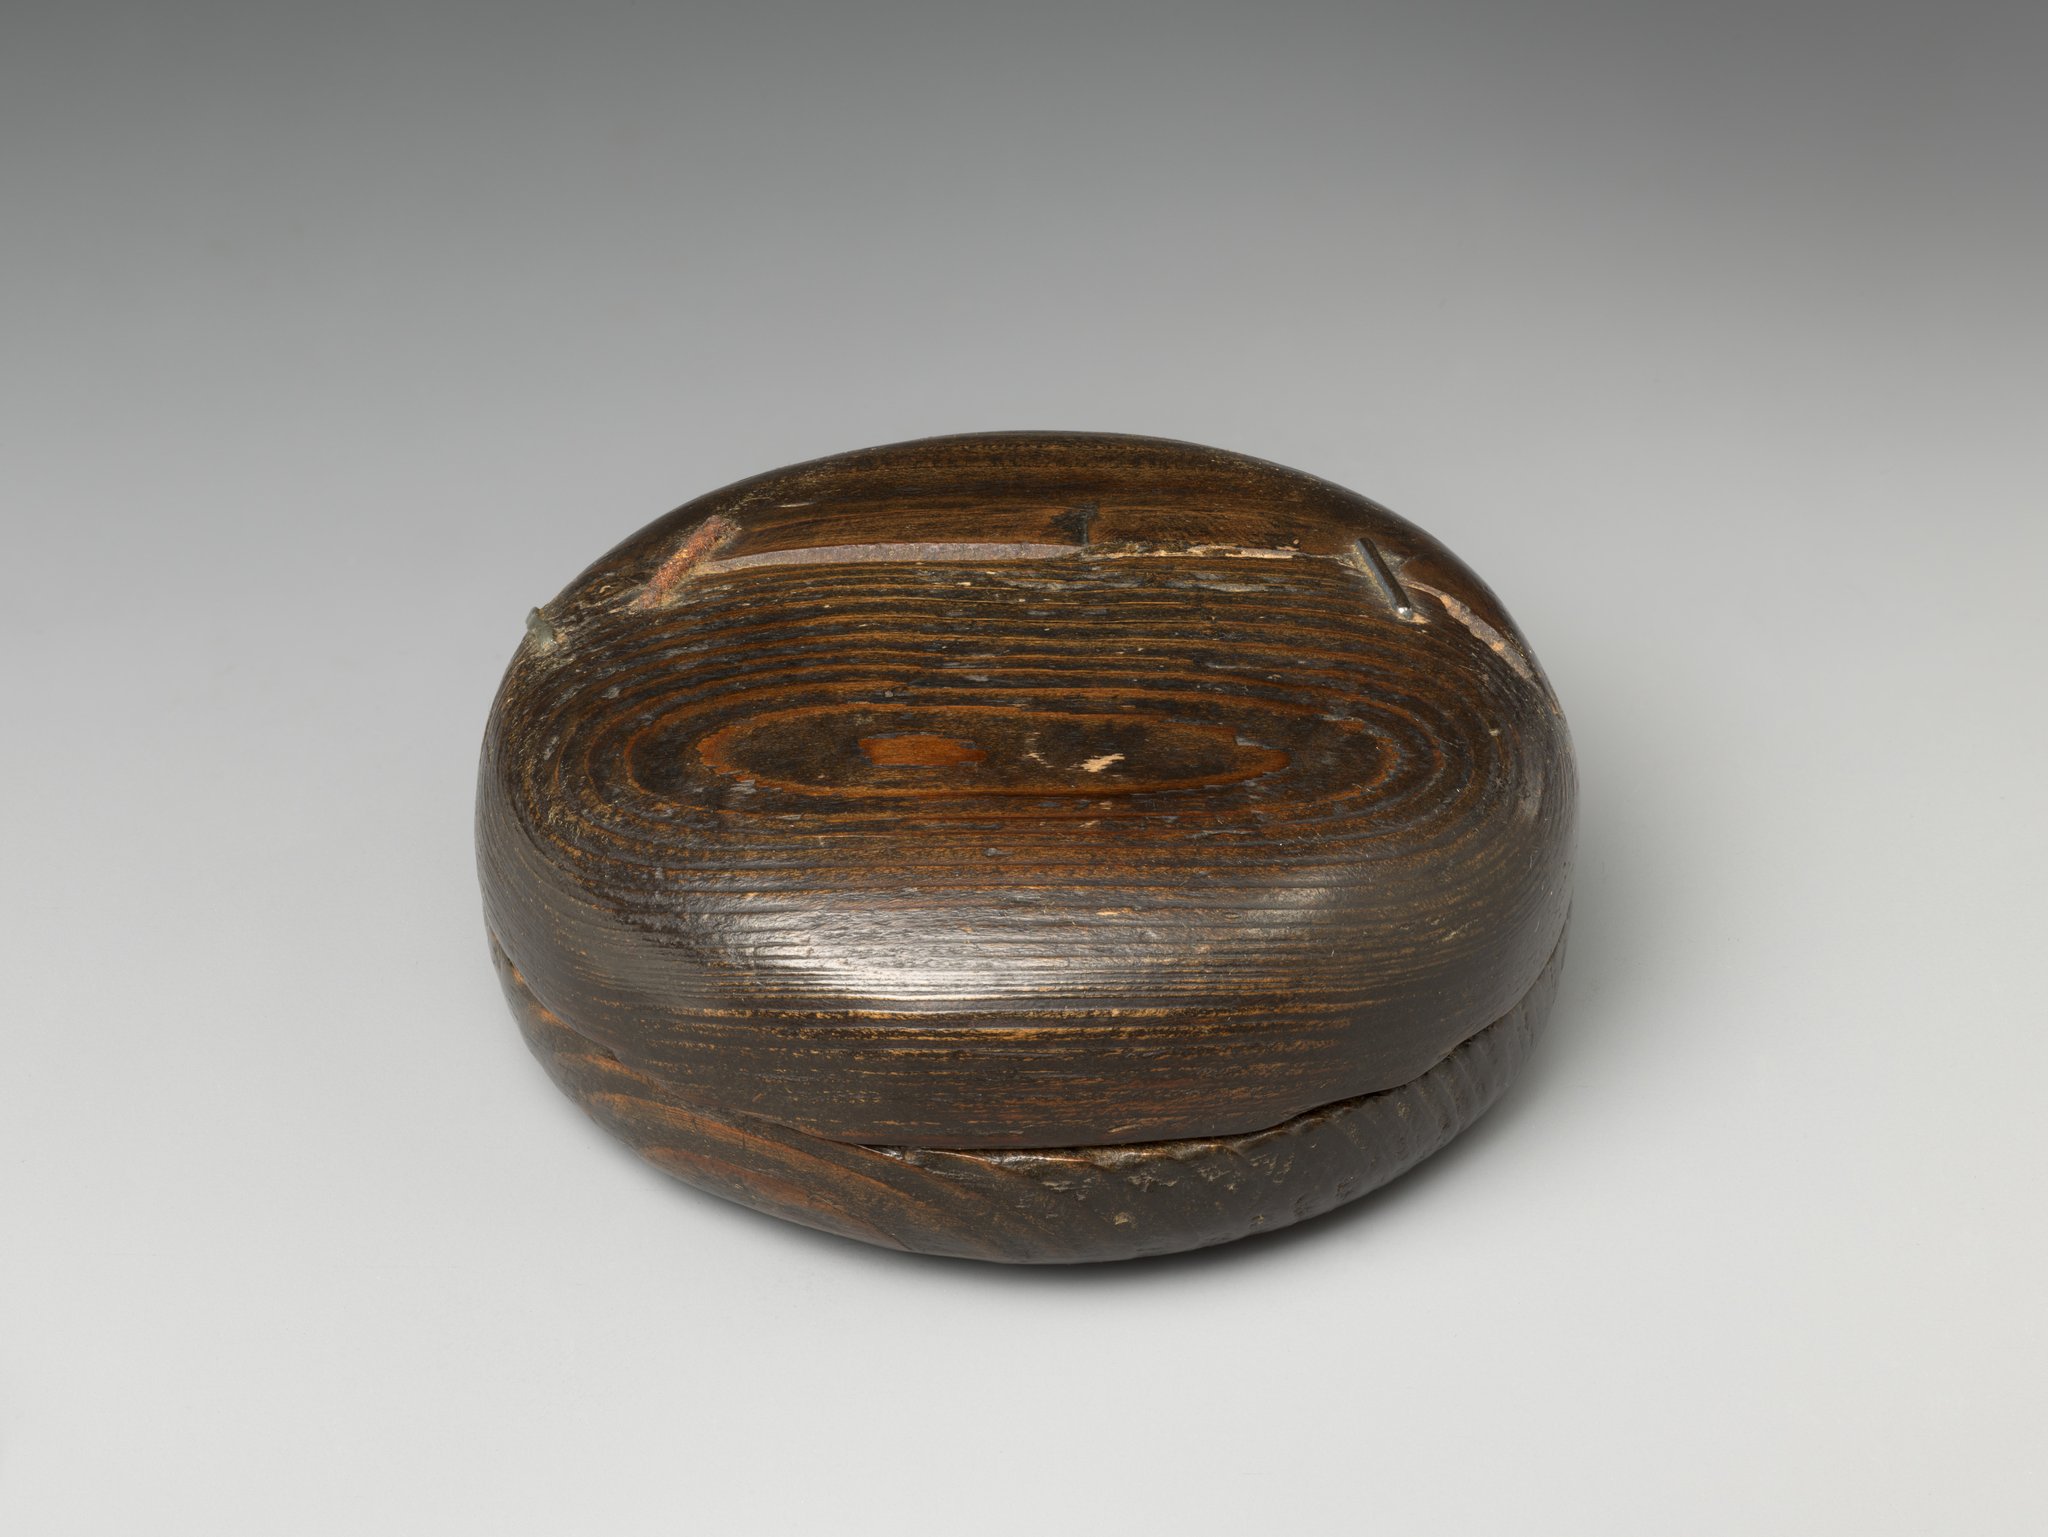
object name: incense box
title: Wooden Kôgo with Rikyû's Kaô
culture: japanese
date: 1501-1600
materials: iron, lacquer, silver, wood